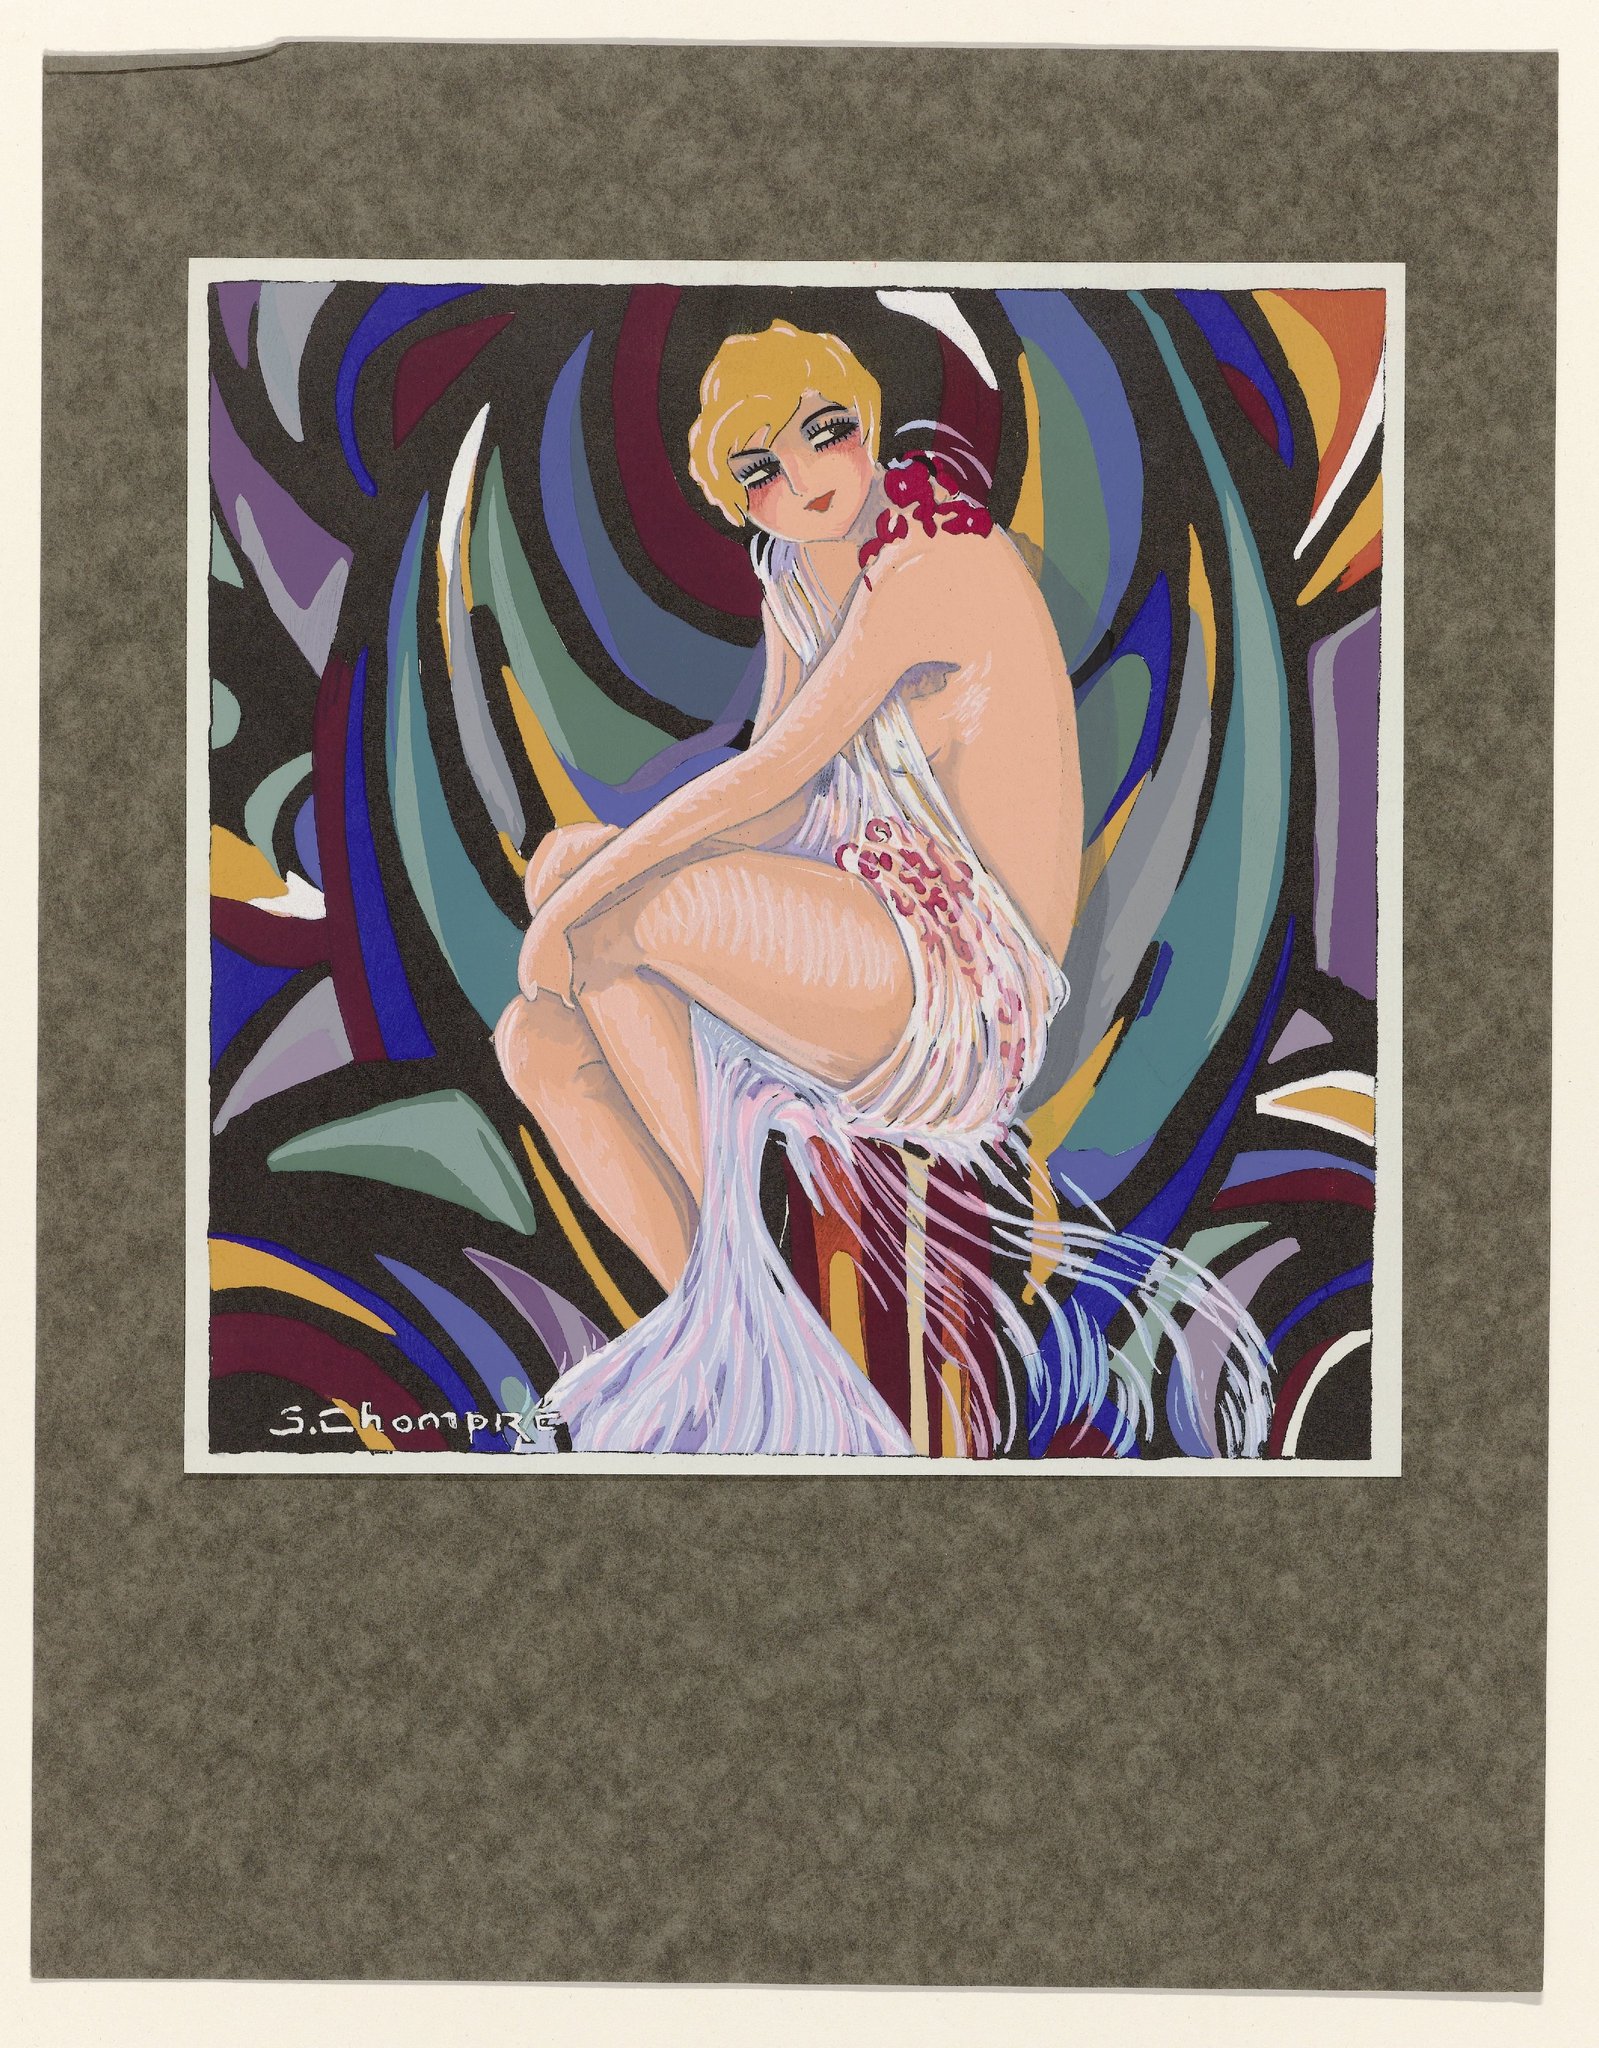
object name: fashion print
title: Femmes Modernes, 1926 : Zittende vrouw, met draperie.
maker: s chompré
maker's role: print maker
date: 1926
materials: gouache, paper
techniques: pochoir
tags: fashion plates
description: Zittende vrouw, met draperie. Tegen fel gekleurde achtergrond. Demi-Nue.